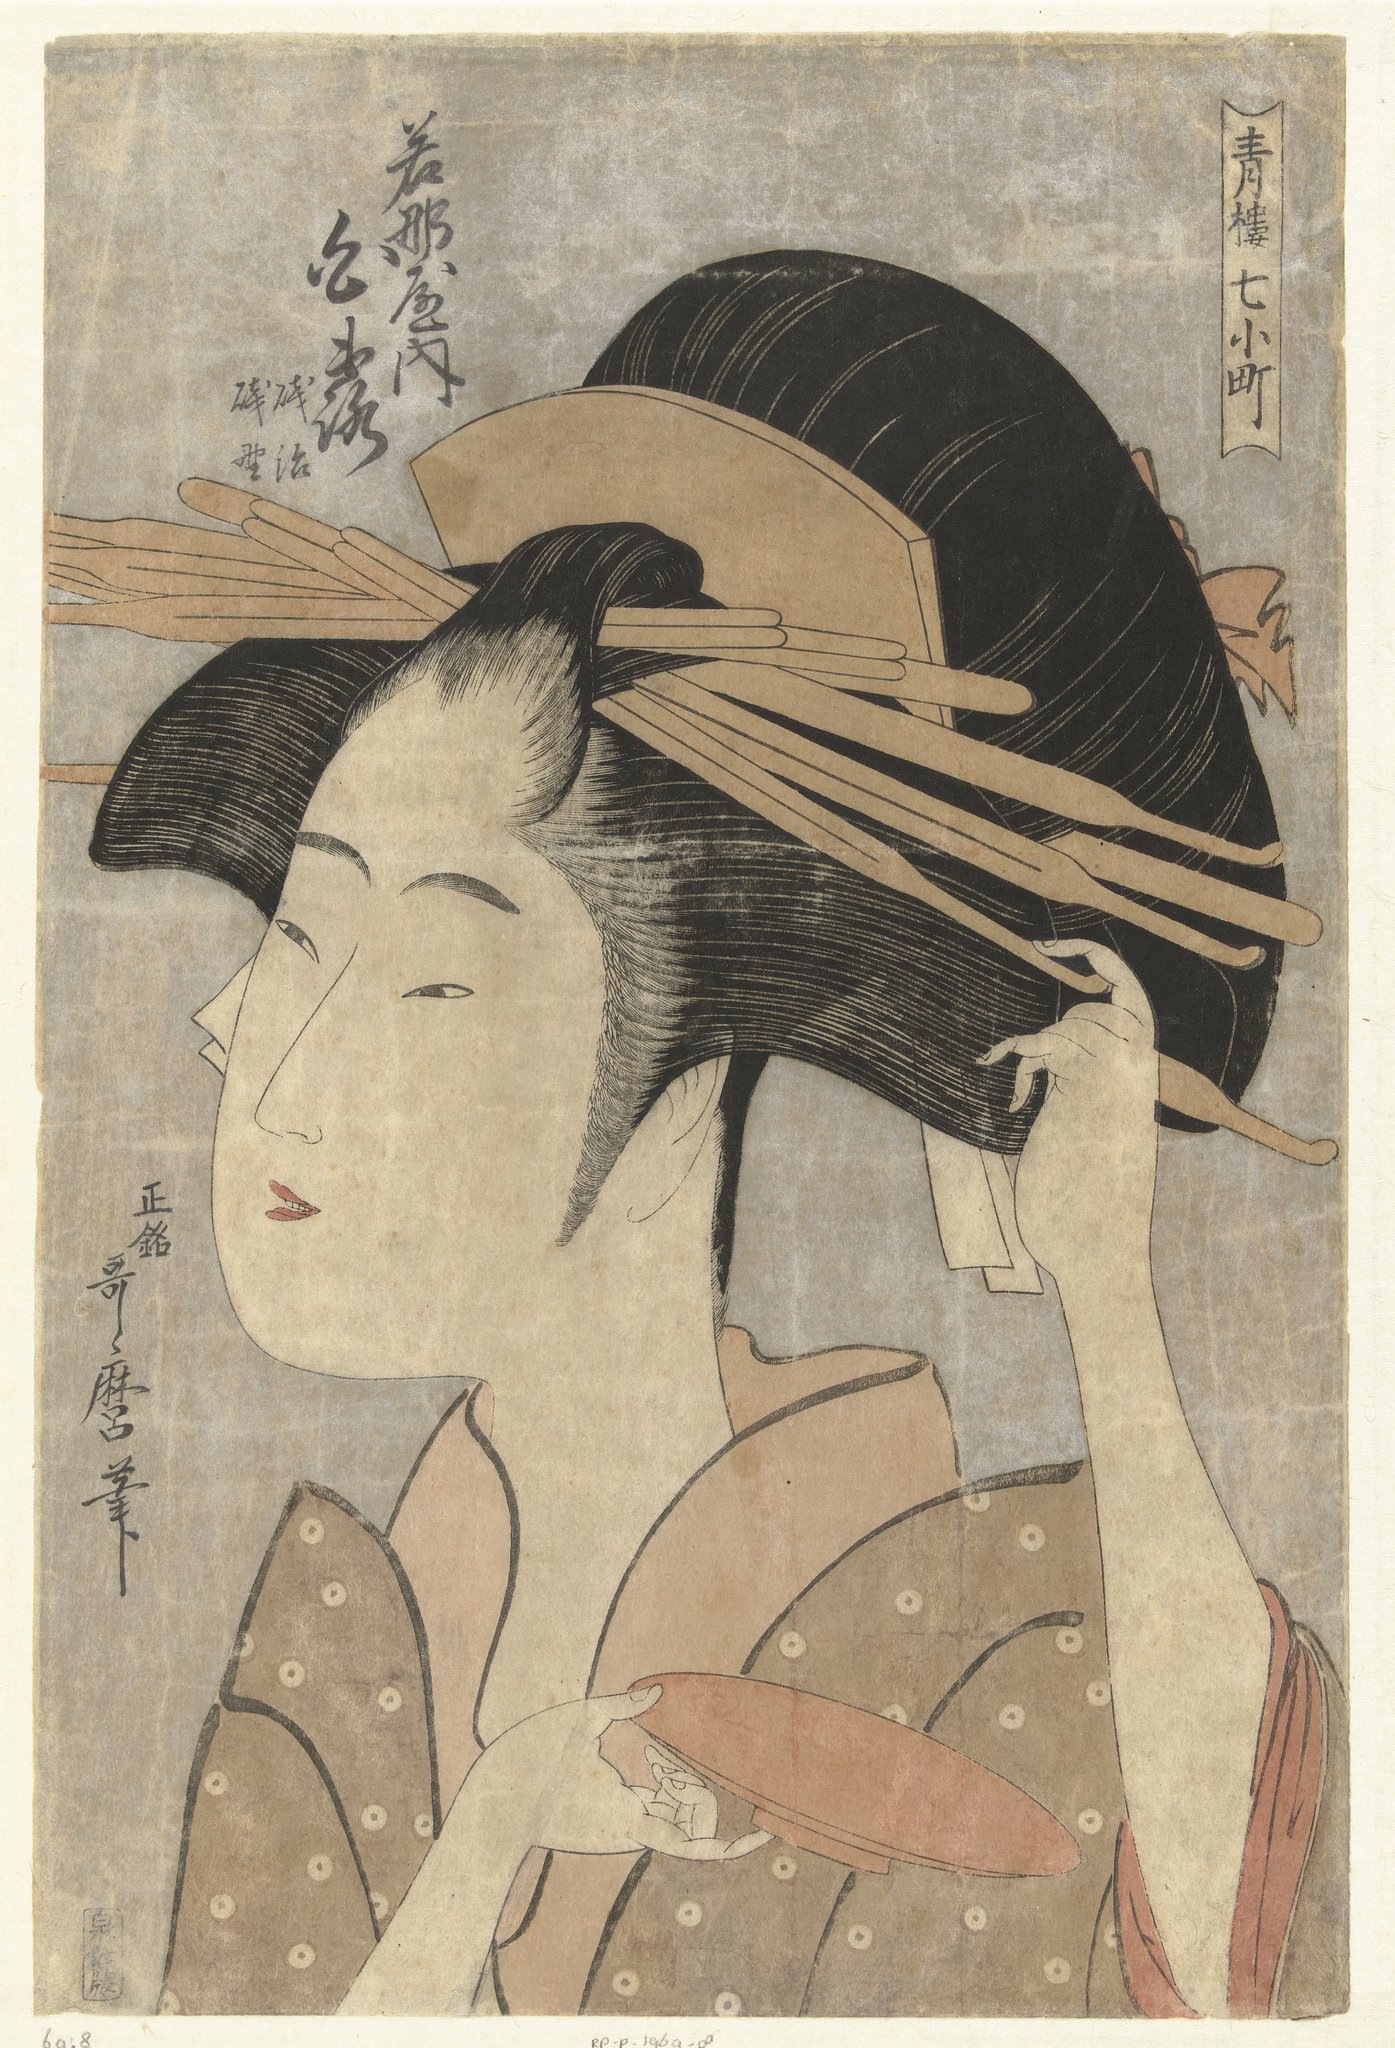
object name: print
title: Wakanaya uchi Shiratsuya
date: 1795-1800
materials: paper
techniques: woodcut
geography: japan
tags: courtesan, hetaera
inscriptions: collector's mark: Lugt 2228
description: Busteportret van courtisane met in rechter hand een schoteltje en met linker hand bij haarpen; tegen grijze mica achtergrond. Naast de prenttitel de namen van haar twee kamuro (jongste hulpen van een courtisane): Tatsuji en Tatsuno.